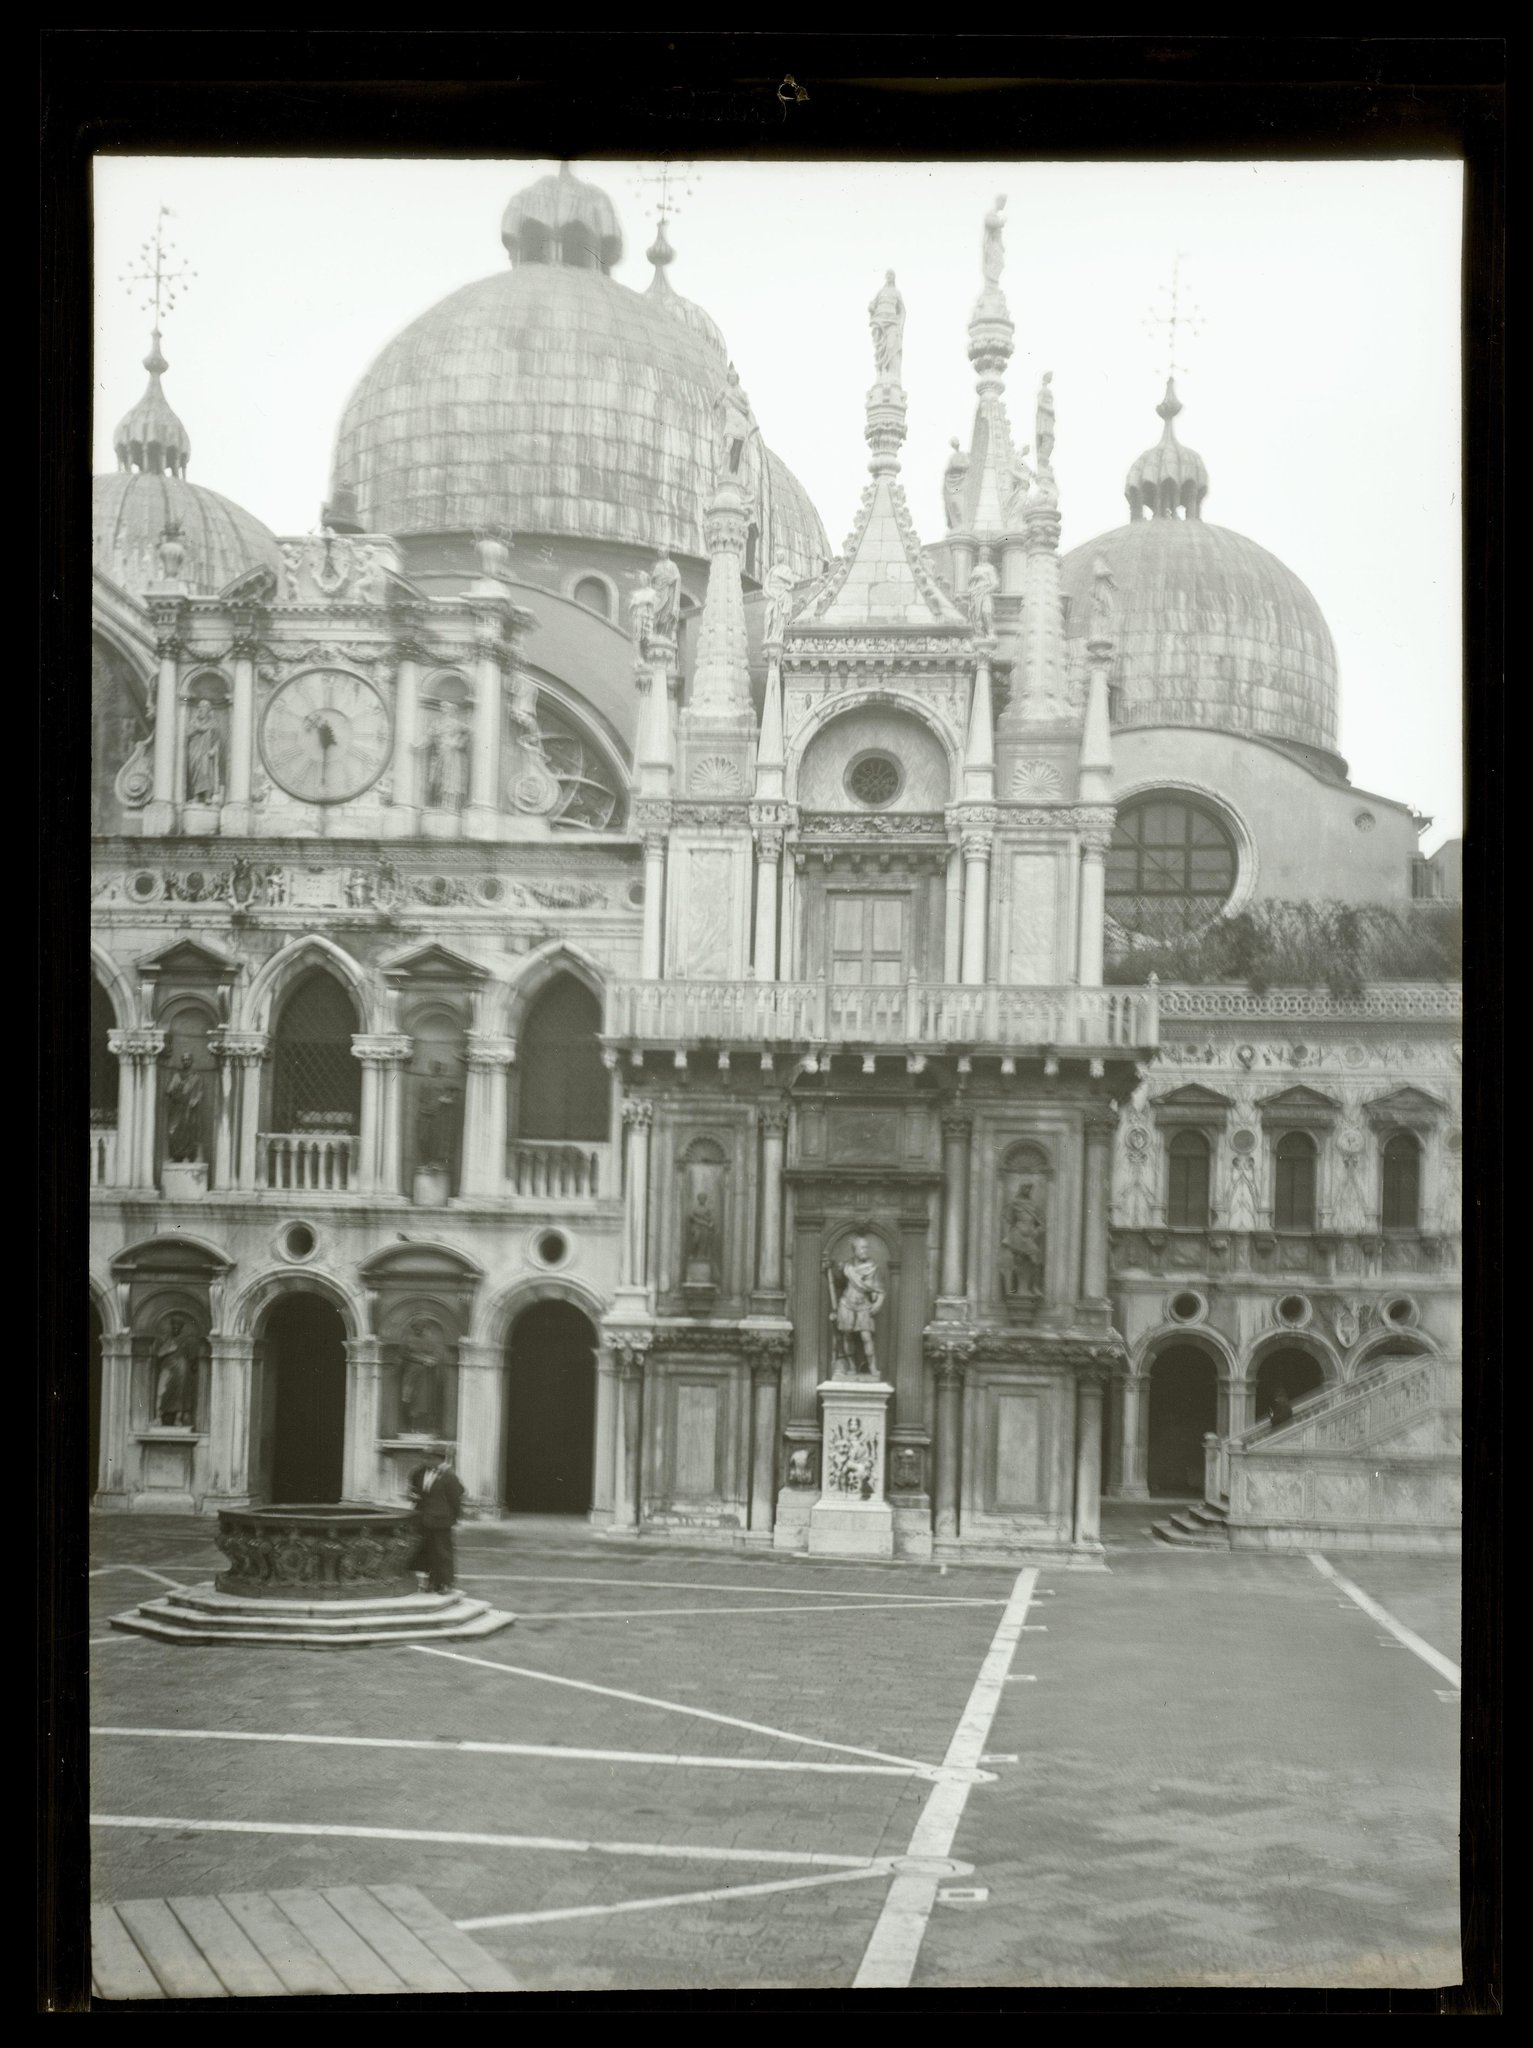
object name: photograph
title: Filmnegatief met opname van Venetië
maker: Anonymous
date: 1907-1935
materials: film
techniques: gelatin silver negative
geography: venice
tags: venice